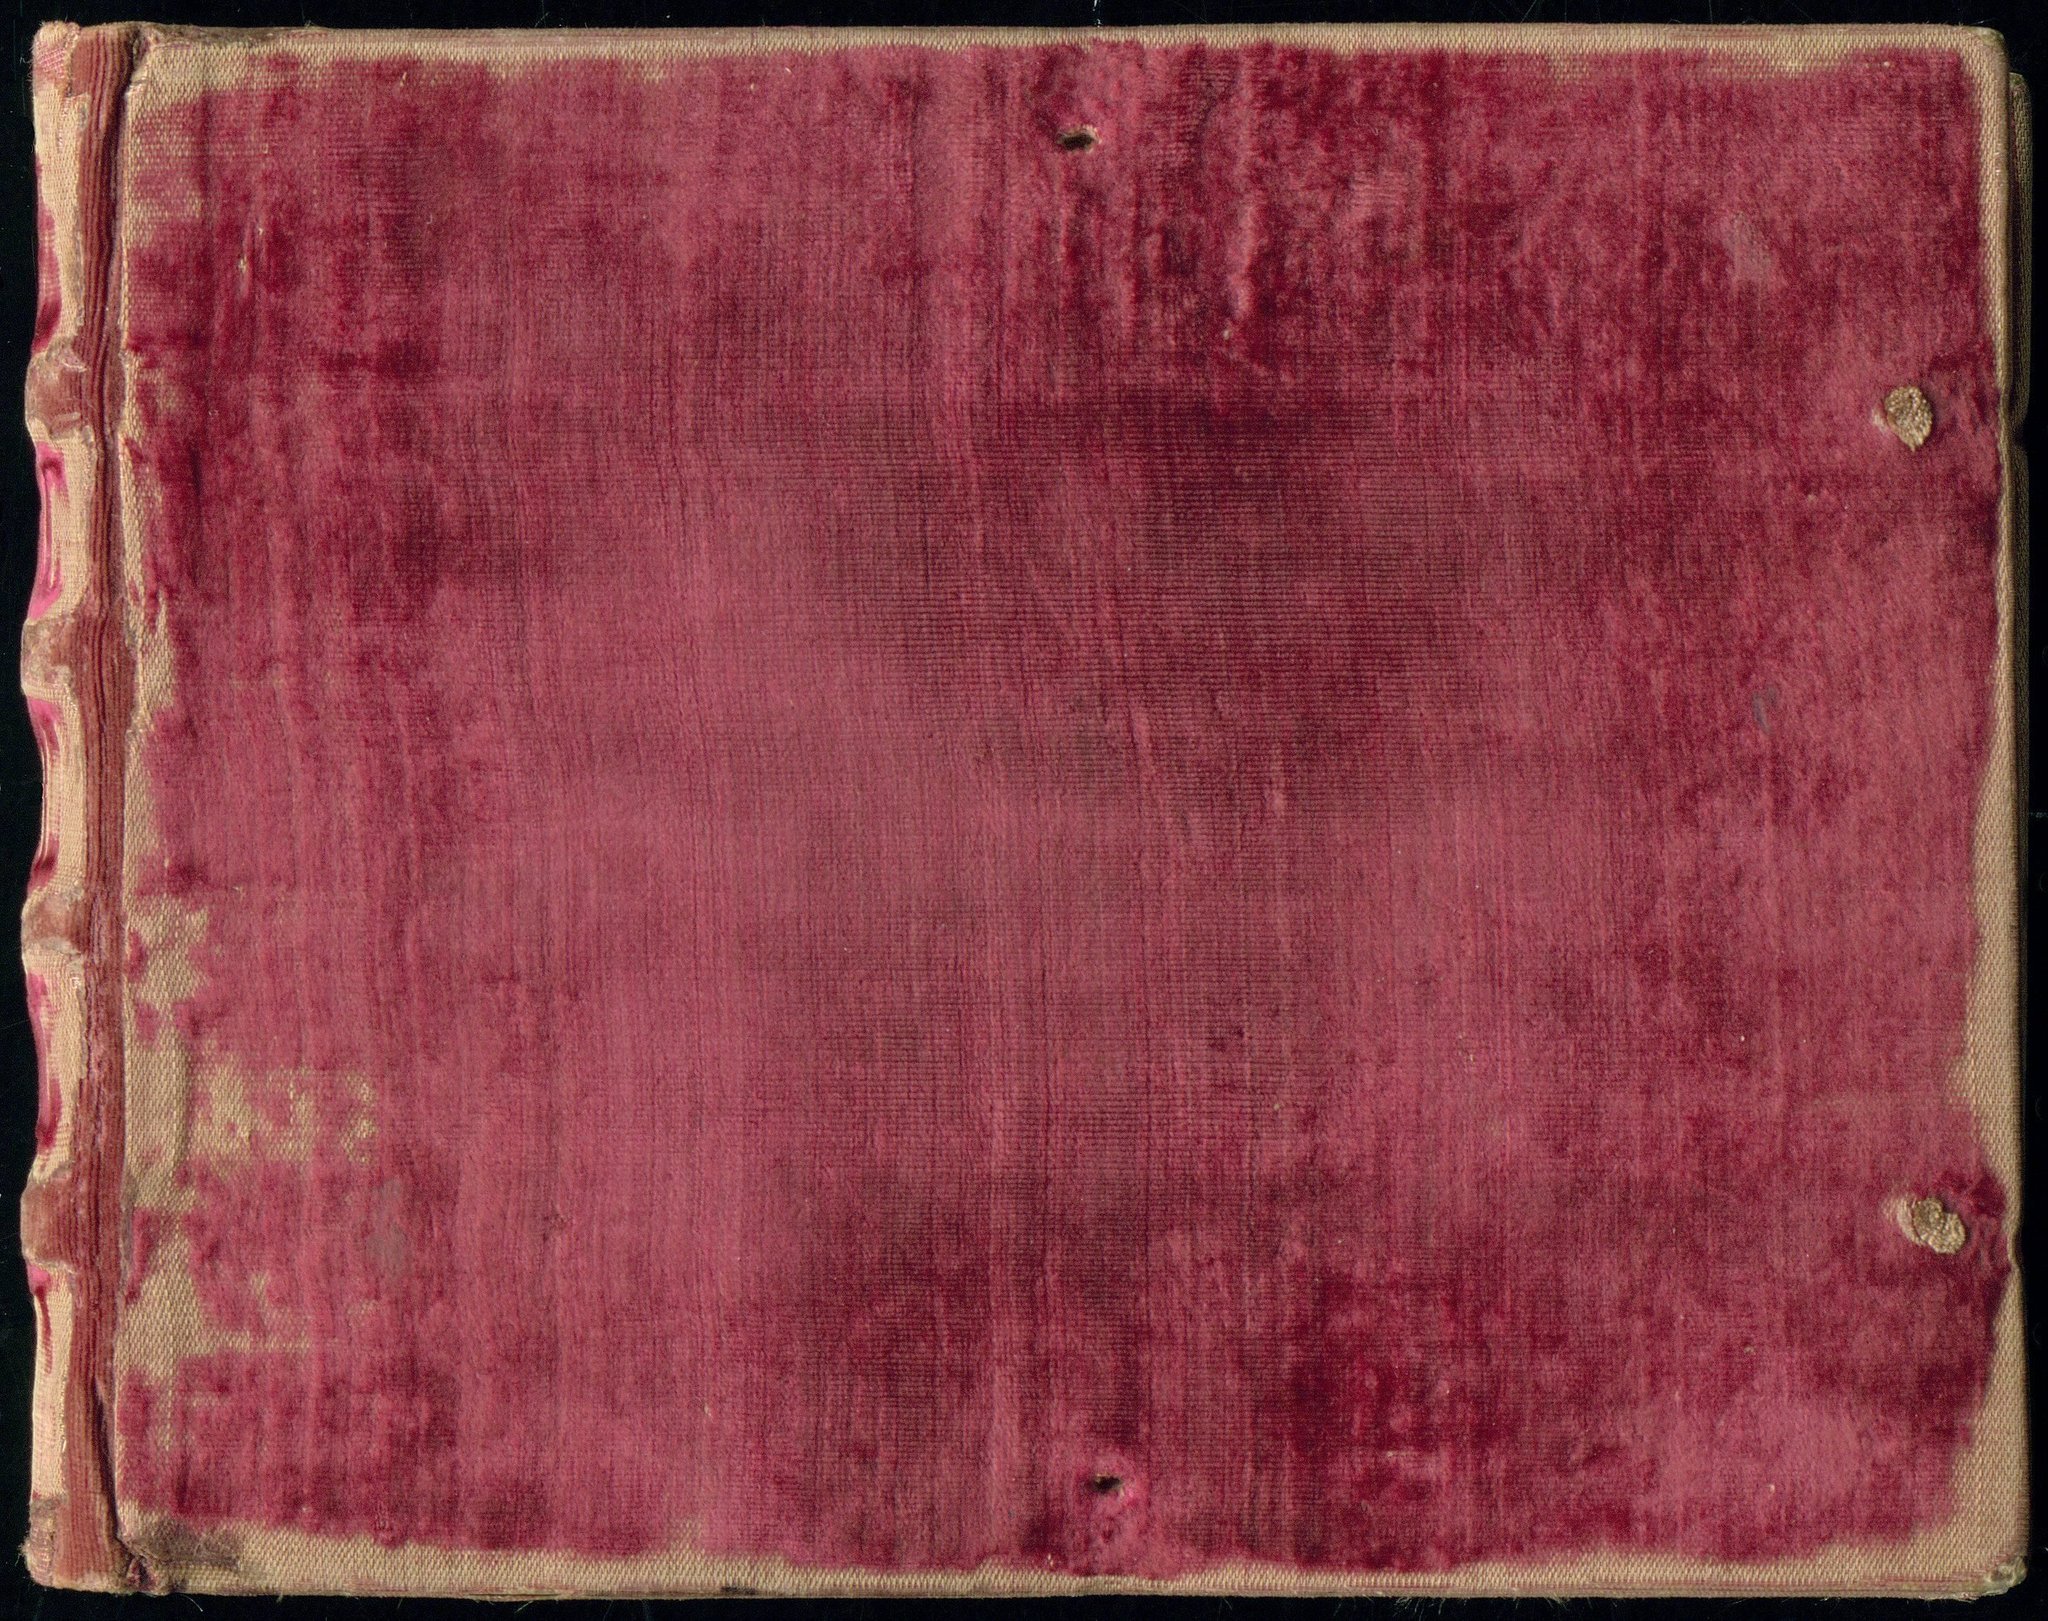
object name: album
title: Het geslachtsregister der heren en vrouwen van Purmerlandt en Ilpendam in twee delen in oblong albumformaat in een kartonnen etui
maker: Anonymous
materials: cardboard, ink, paper, velvet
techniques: brush, pen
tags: picture, painting, armorial bearing, heraldry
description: Geslachtsregister in twee delen. Twee alba bekleed met rood fluweel. In een foedraal bronskleurig reliëfkarton.